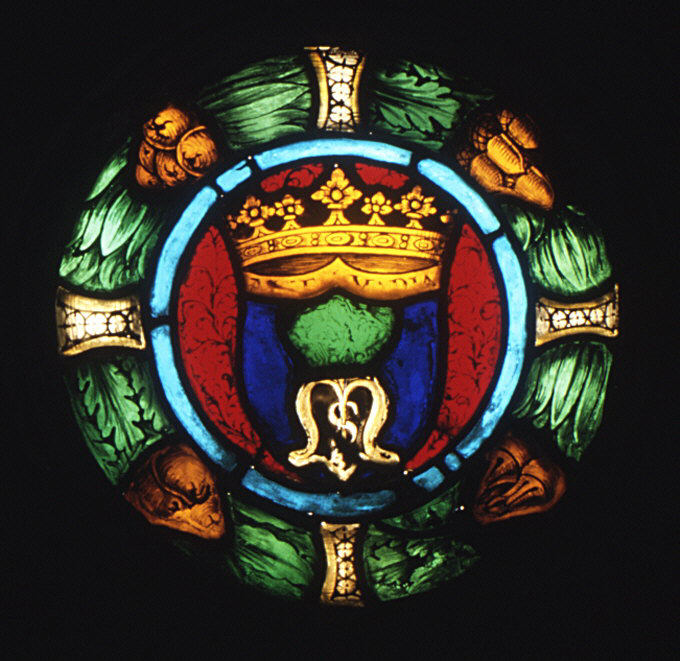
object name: roundel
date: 1501-1533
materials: glass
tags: coat of arms